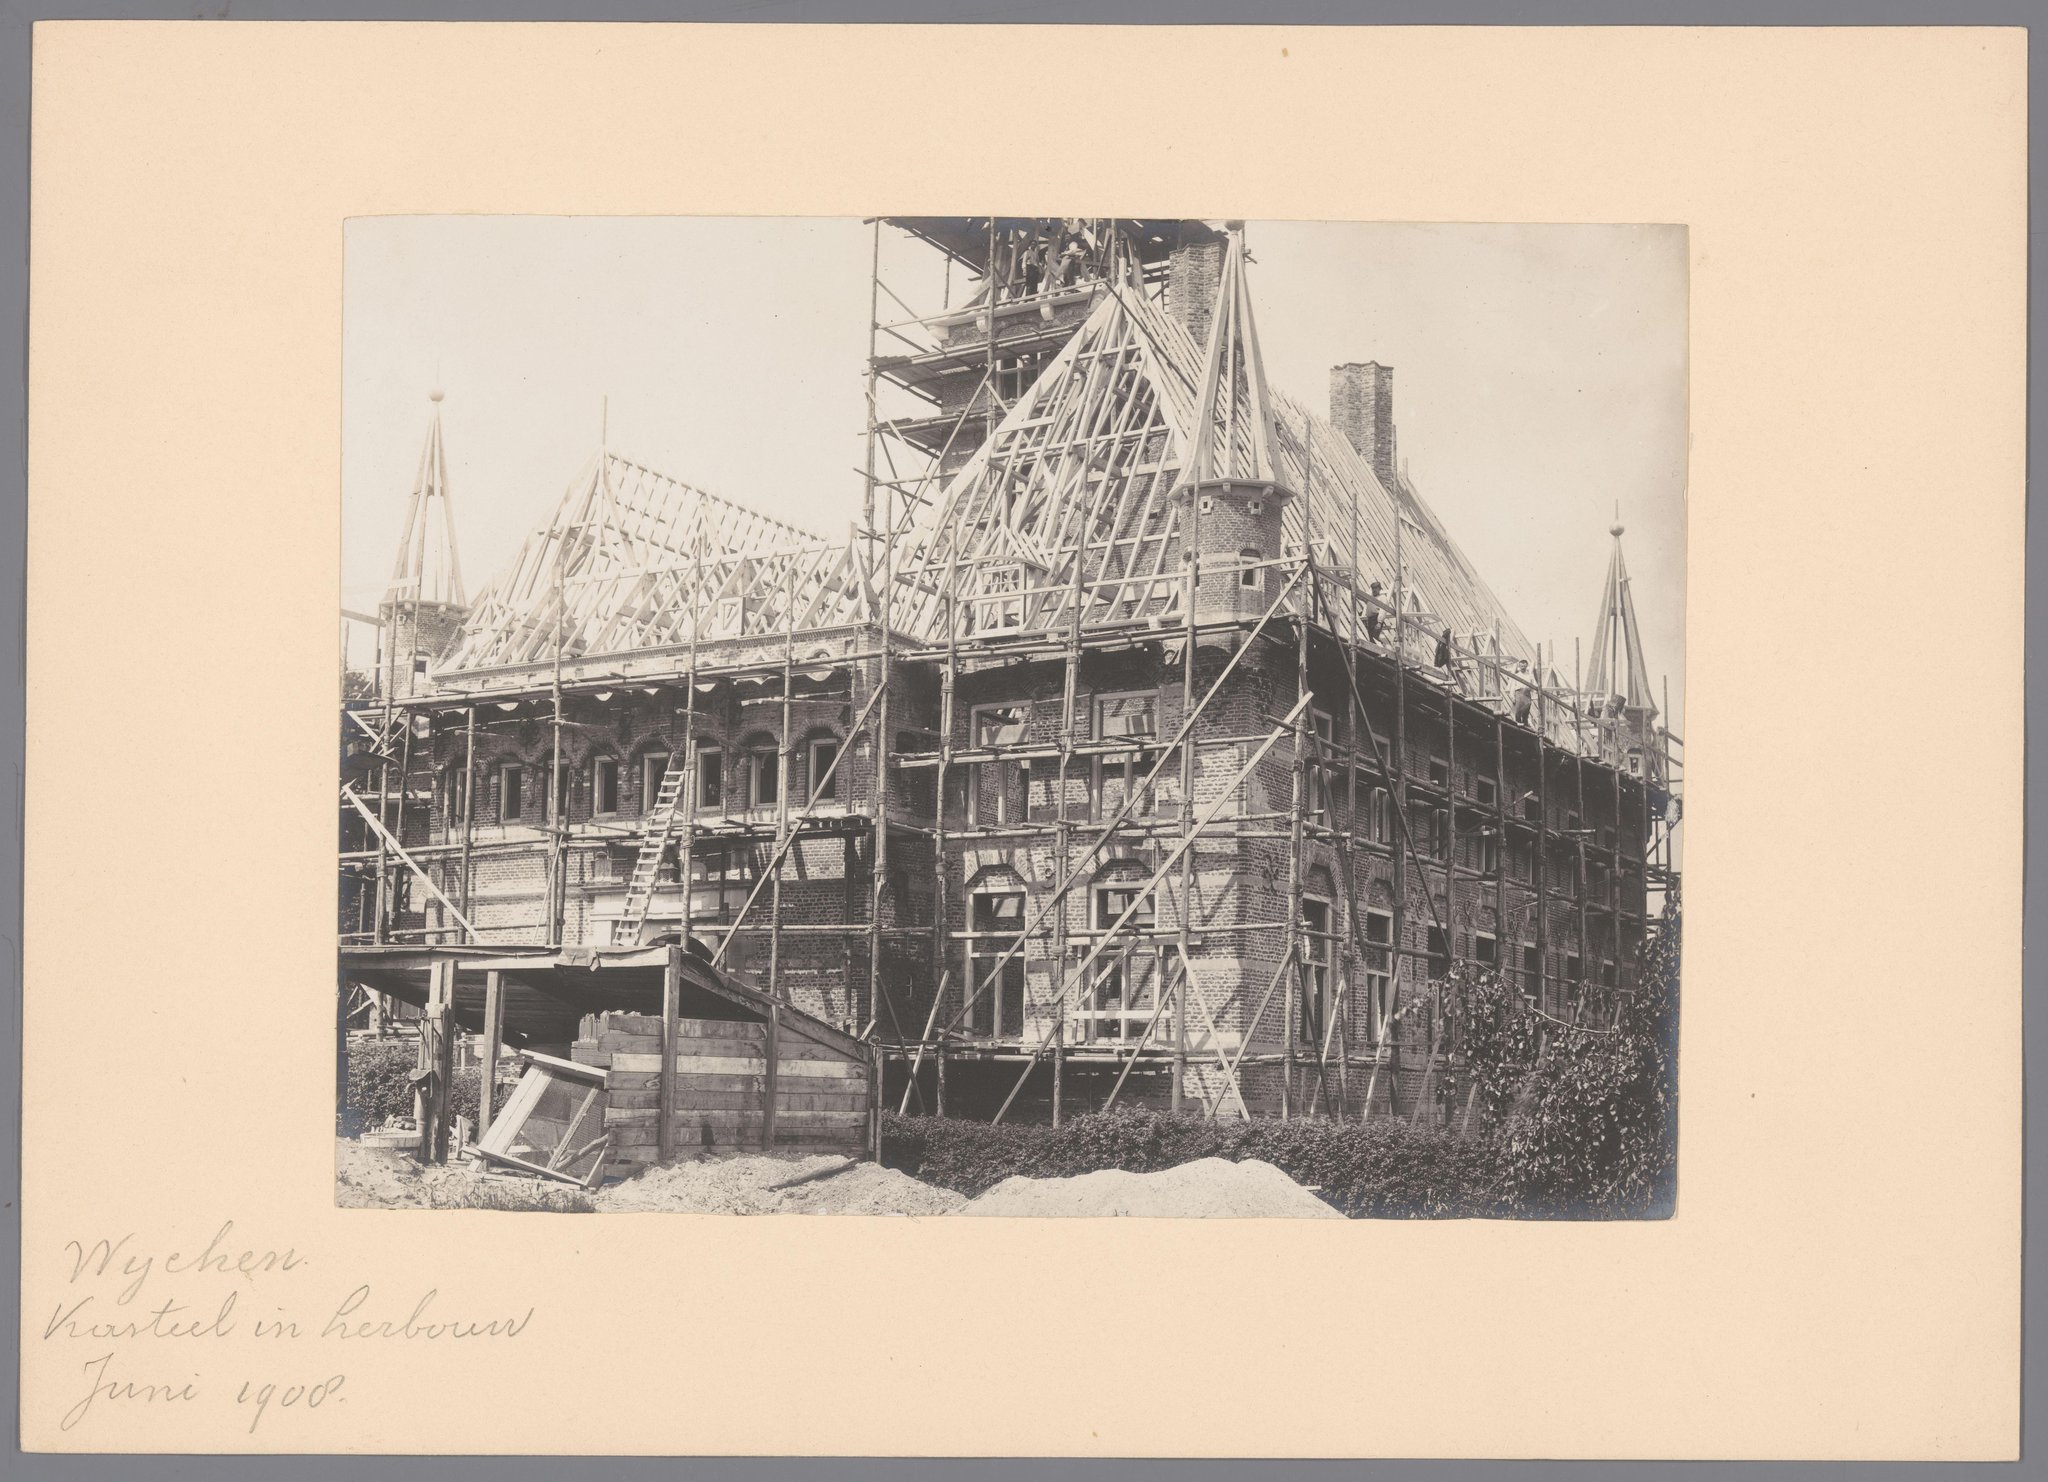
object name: photograph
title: Herbouw van het Kasteel van Wijchen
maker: anoniem (monumentenzorg)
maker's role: fotograaf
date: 1908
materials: cardboard, photographic support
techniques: gelatin silver print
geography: wijchen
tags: castle, landscape with tower or castle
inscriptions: annotation: ‘Wijchen/ Kasteel in herbouw/ Juni 1908’